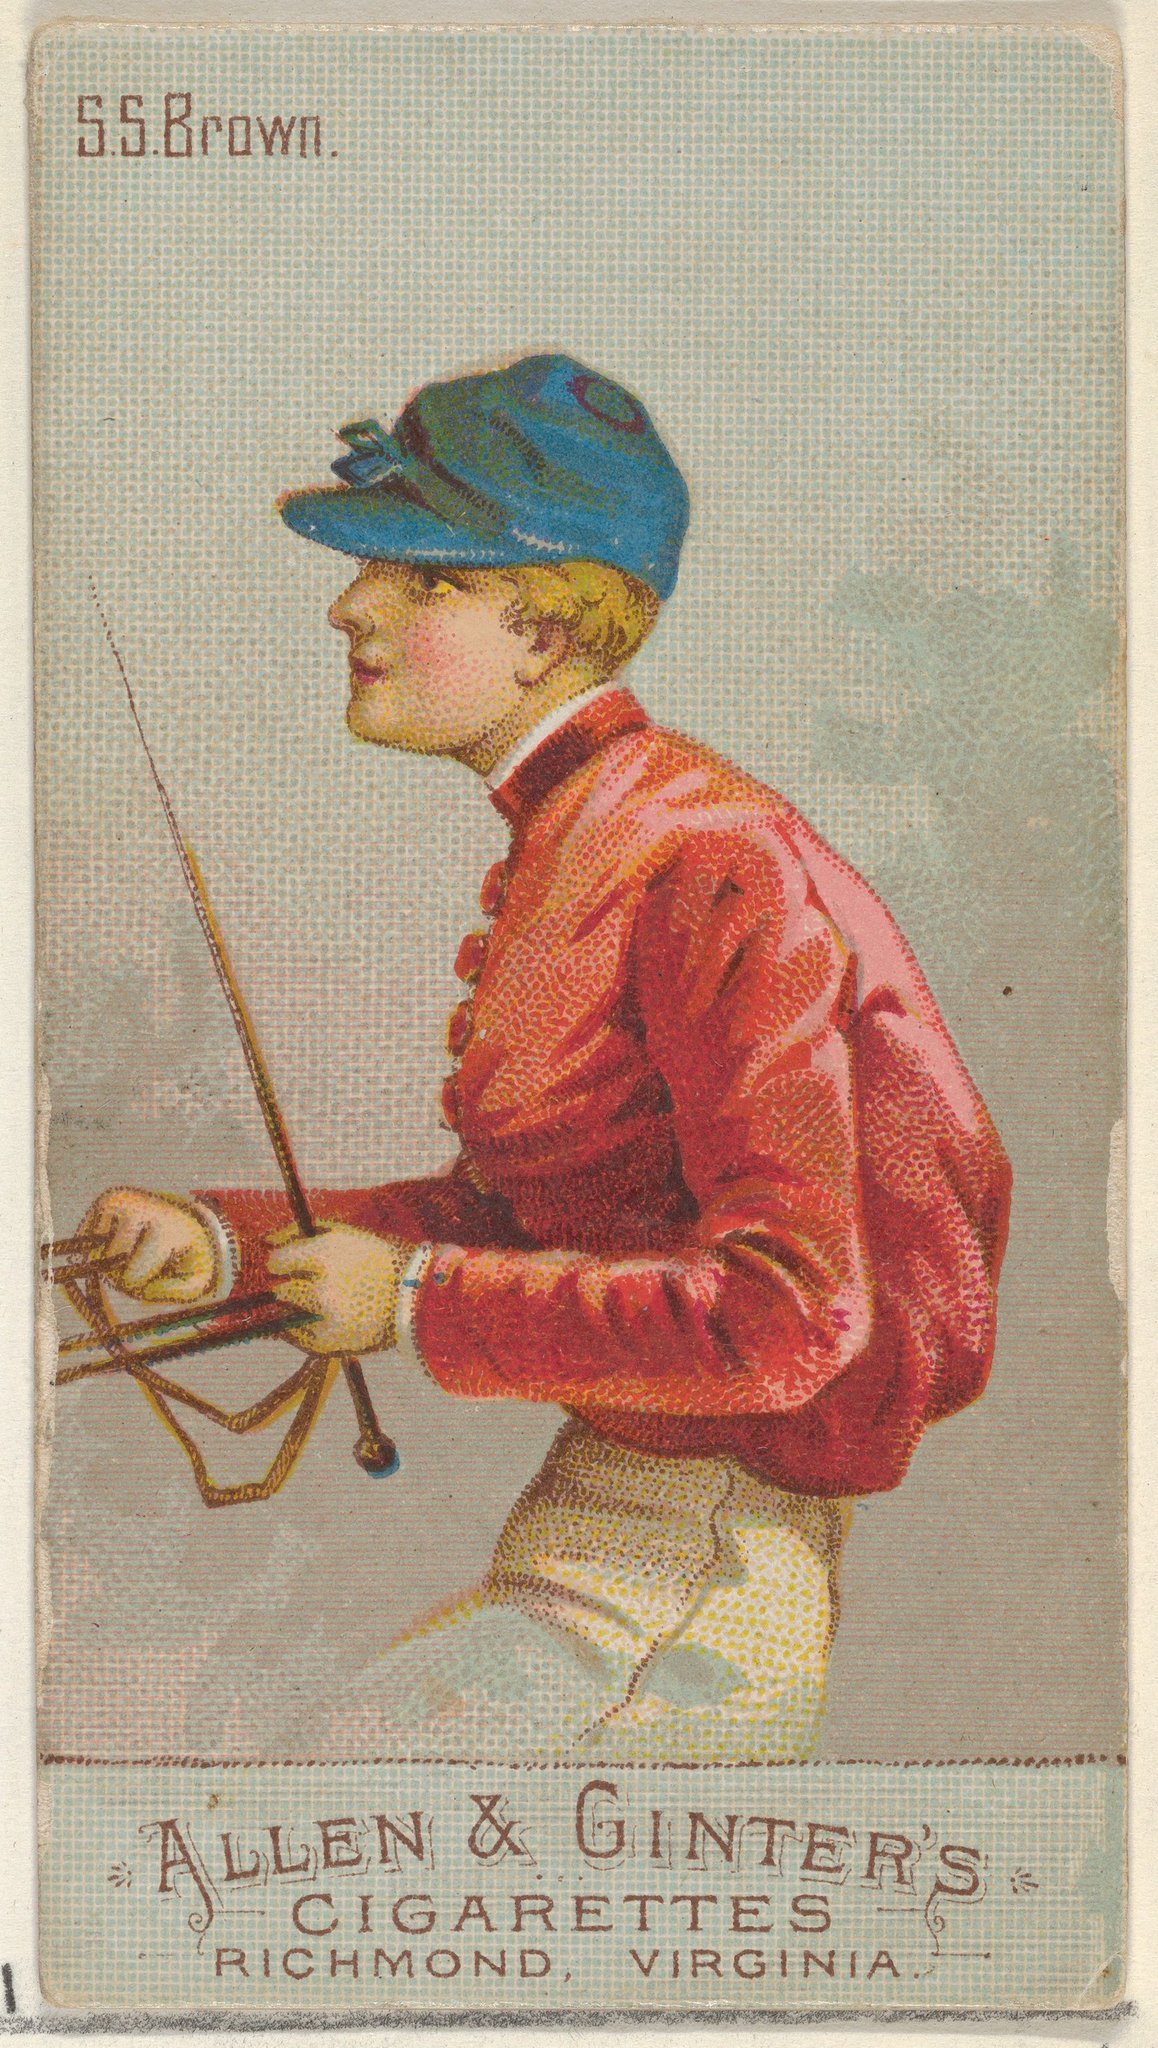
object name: print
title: S.S. Brown, from the Racing Colors of the World series (N22b) for Allen & Ginter Cigarettes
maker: allen & ginter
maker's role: publisher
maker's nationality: american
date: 1888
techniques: color lithograph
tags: men,profiles,athletes,jockeys